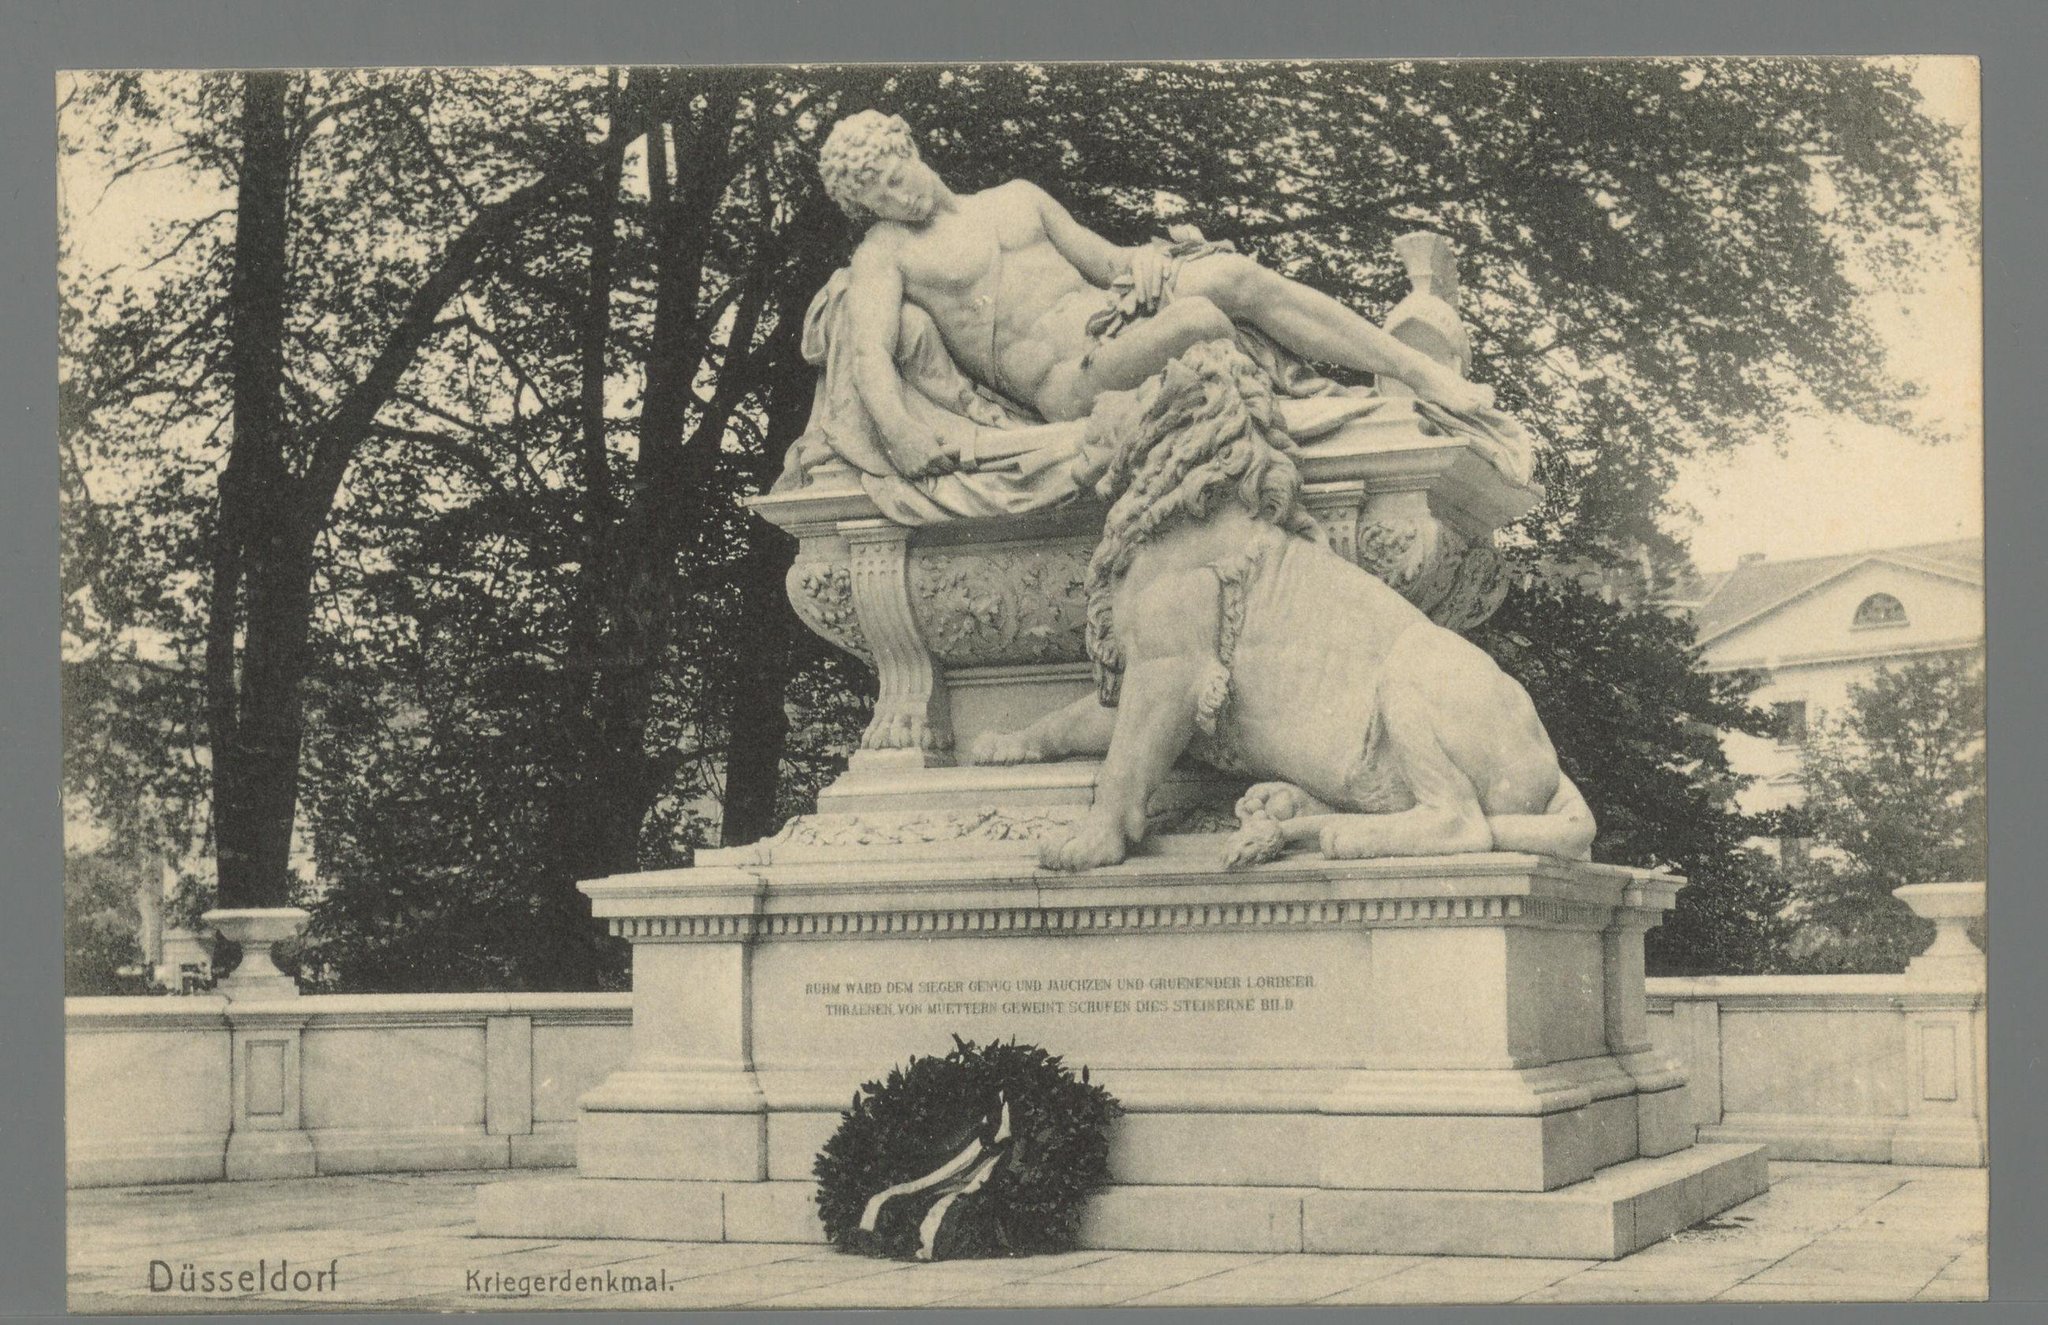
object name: ansichtkaart, prentbriefkaart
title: Düsseldorf. Kriegerdenkmal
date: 1905-1930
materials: cardboard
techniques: photograph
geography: dusseldorf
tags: park, garland, wreath, monument, statue